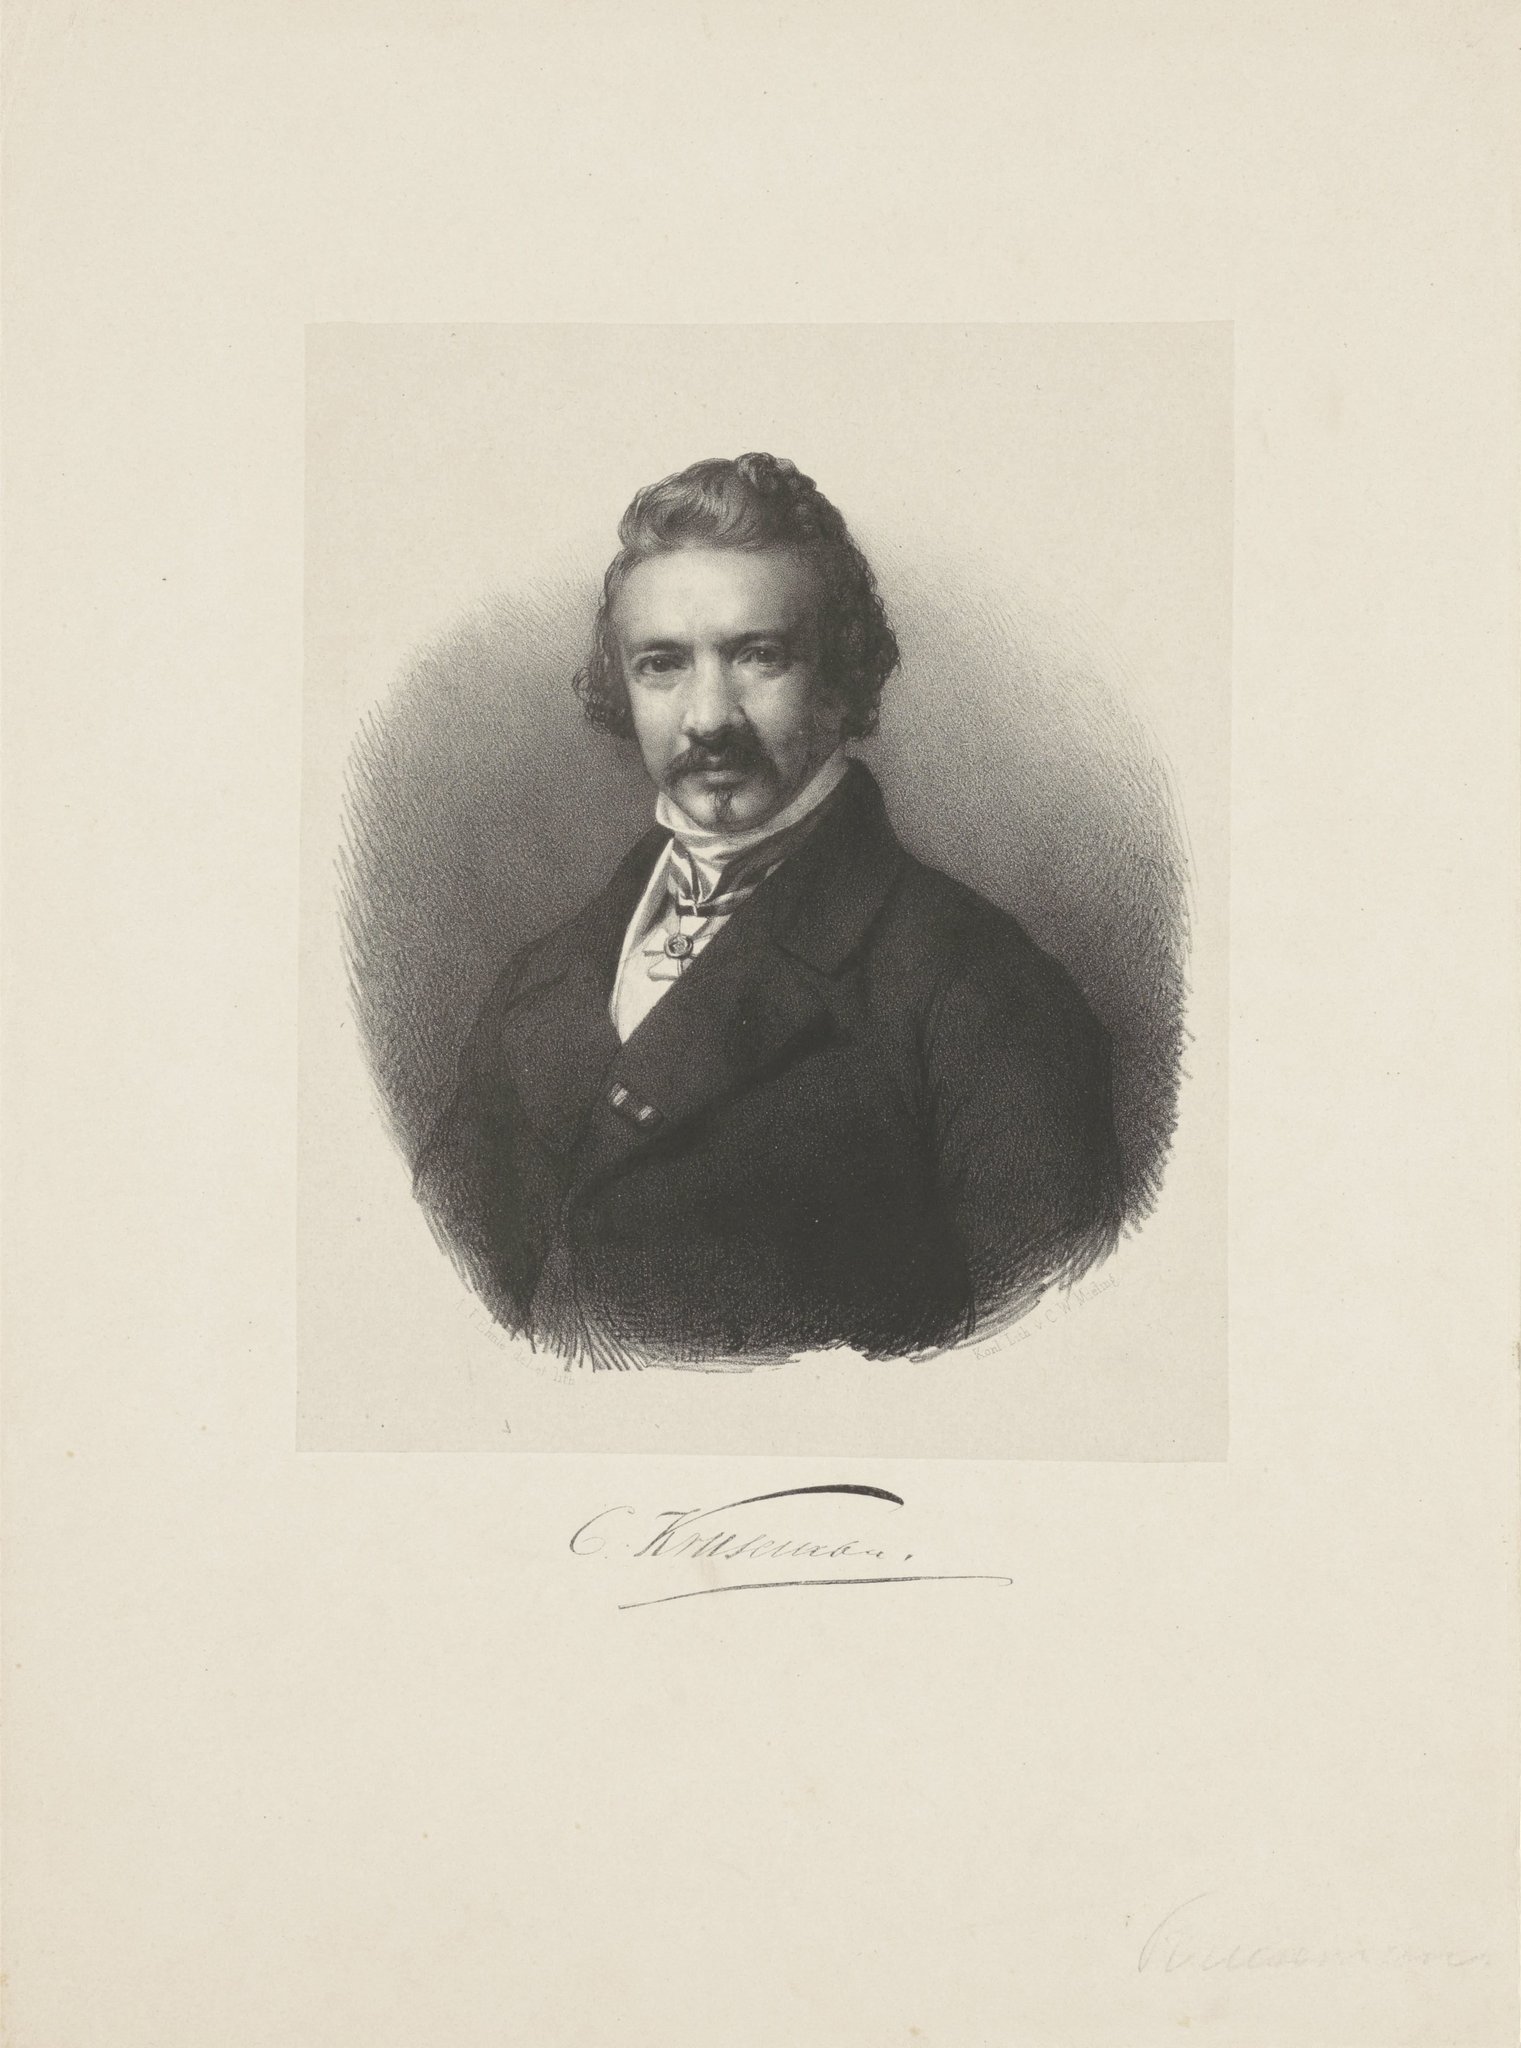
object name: print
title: Portret van Cornelis Kruseman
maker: adrianus johannes ehnle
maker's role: draughtsman, print maker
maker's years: 1819-1863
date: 1829-1853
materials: paper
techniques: lithograph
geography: netherlands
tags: amsterdam, painter, print maker, cornelis kruseman, historical persons (+ (full) bust portrait)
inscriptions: collector's mark: Lugt 2228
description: De geportretteerde draagt een ordeteken op de revers van zijn jas en om zijn hals. Onder het portret zijn signatuur.